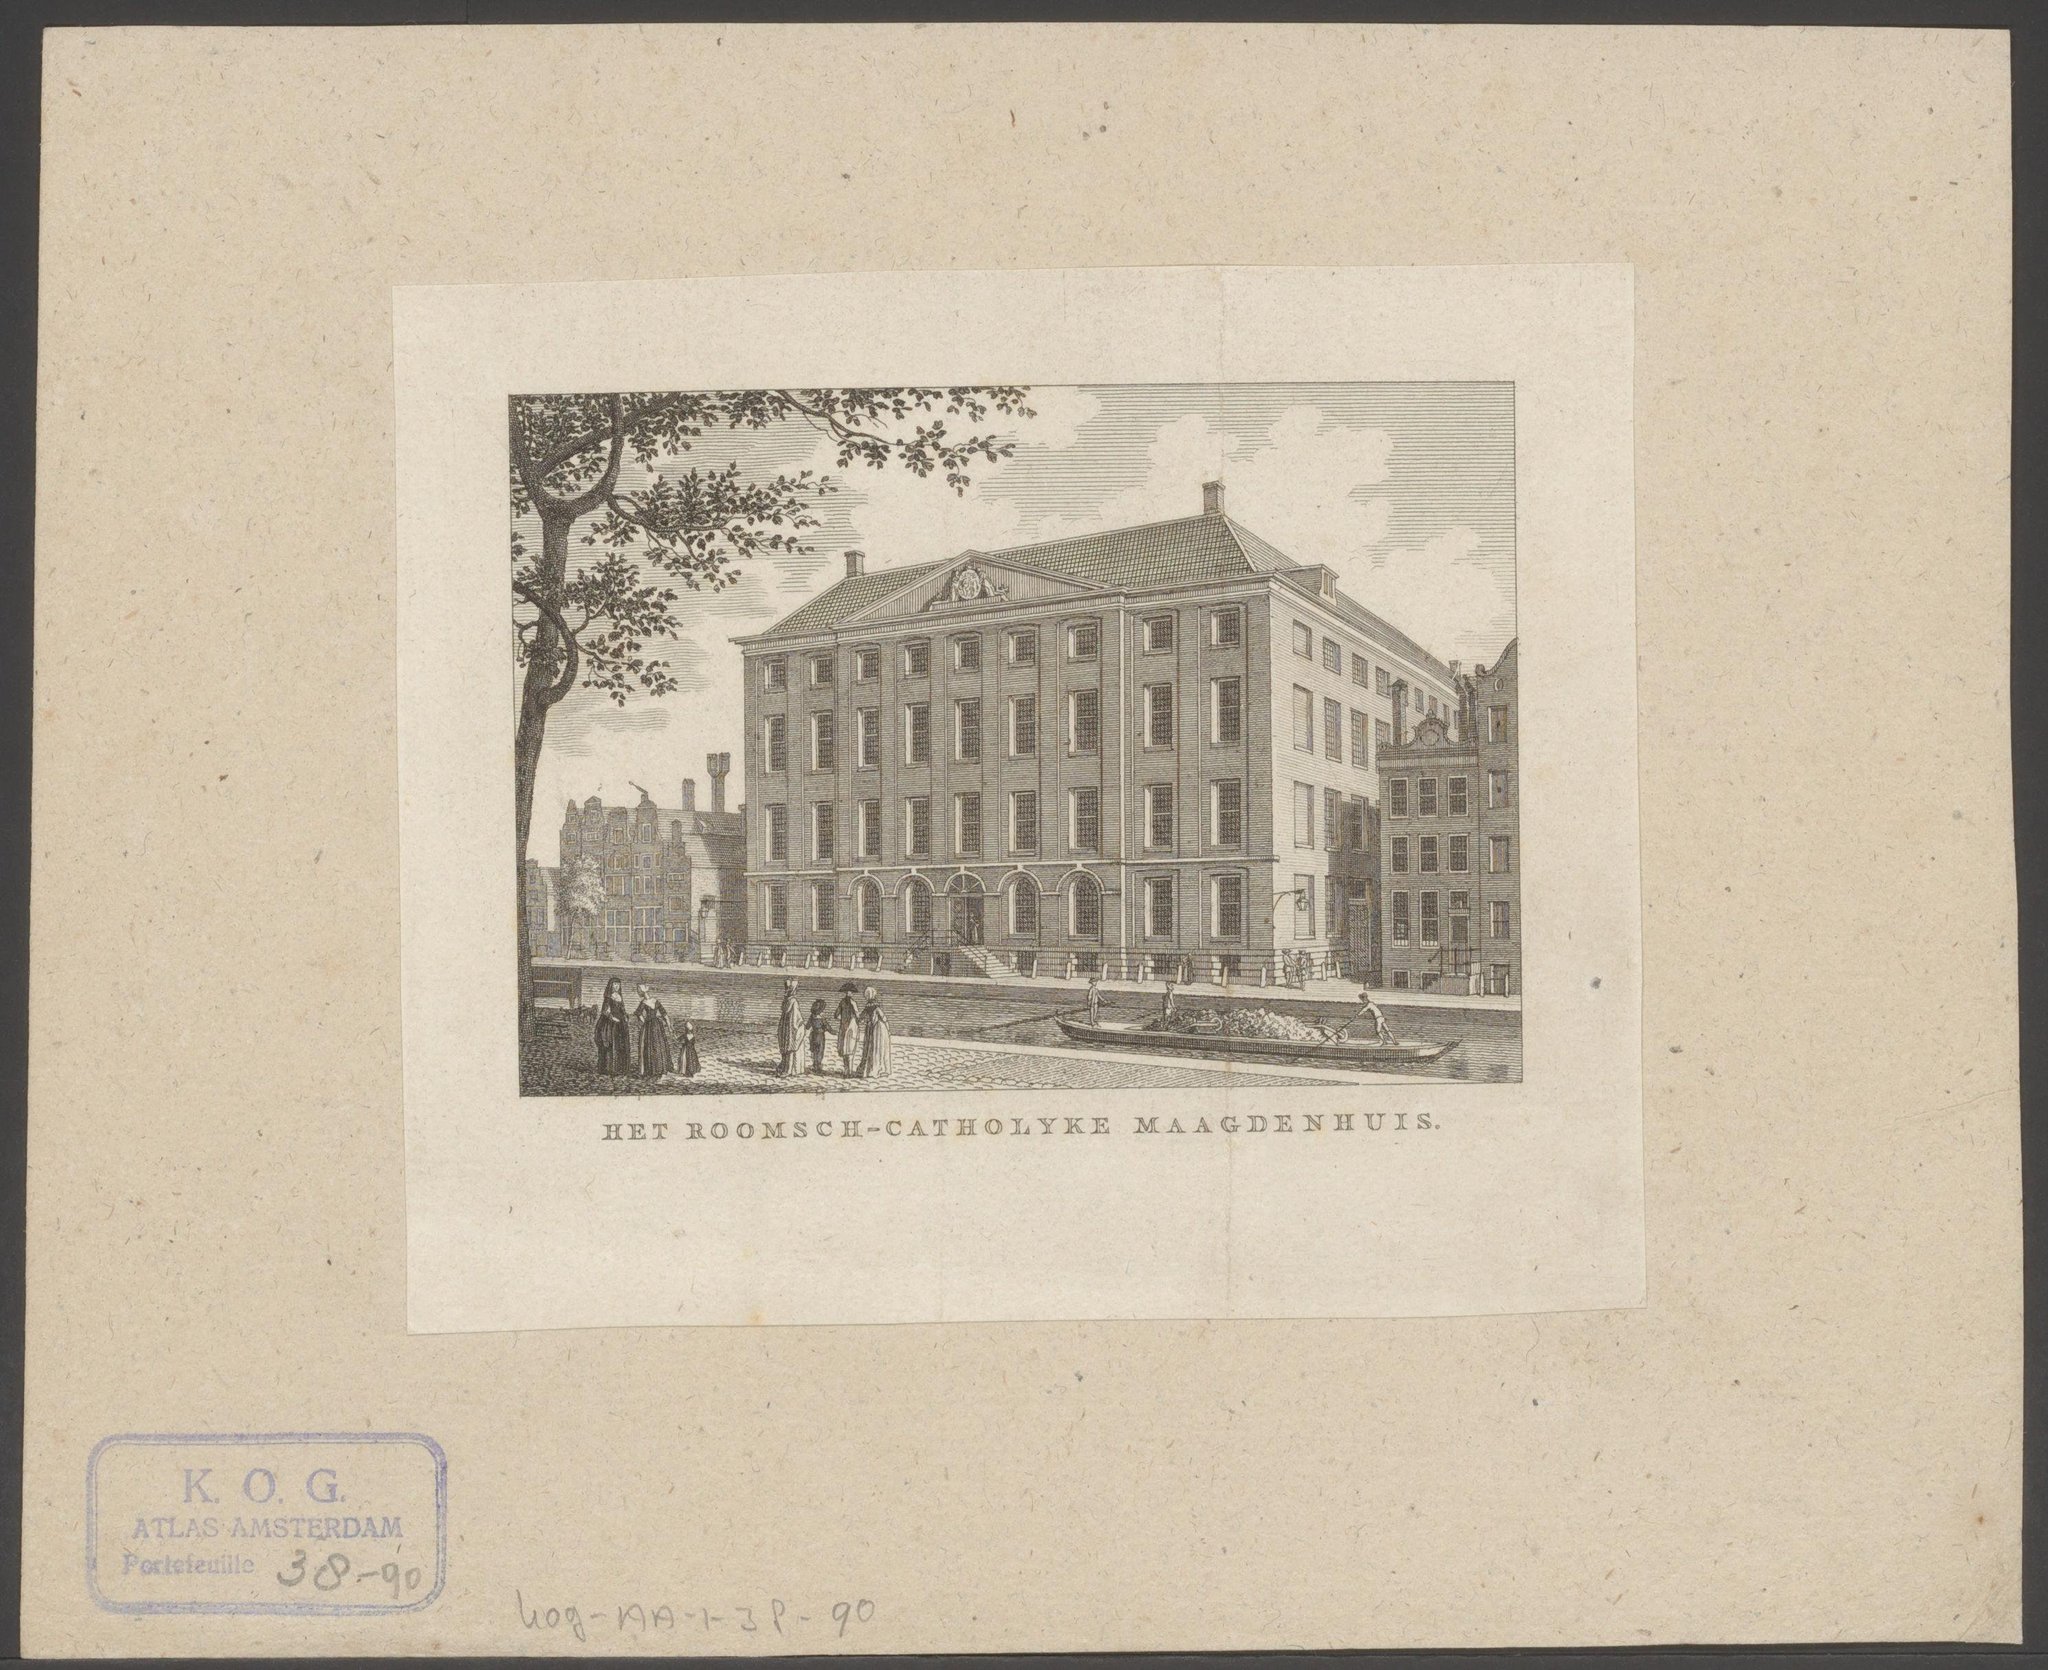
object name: print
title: Het Roomsch-Catholyke Maagdenhuis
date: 1789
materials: paper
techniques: etching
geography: northern netherlands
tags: orphanage, canals, waters (in city) (+ city(-scape) with figures, staffage)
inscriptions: collector's mark: Lugt 1641b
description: Onderwerpsrubriek binnen de Atlas Amsterdam: Armwezen en liefdadige instellingen: II. Kerkelijke inrichtingen: Rooms-Katholijk Maagden of Meisjesweeshuis.